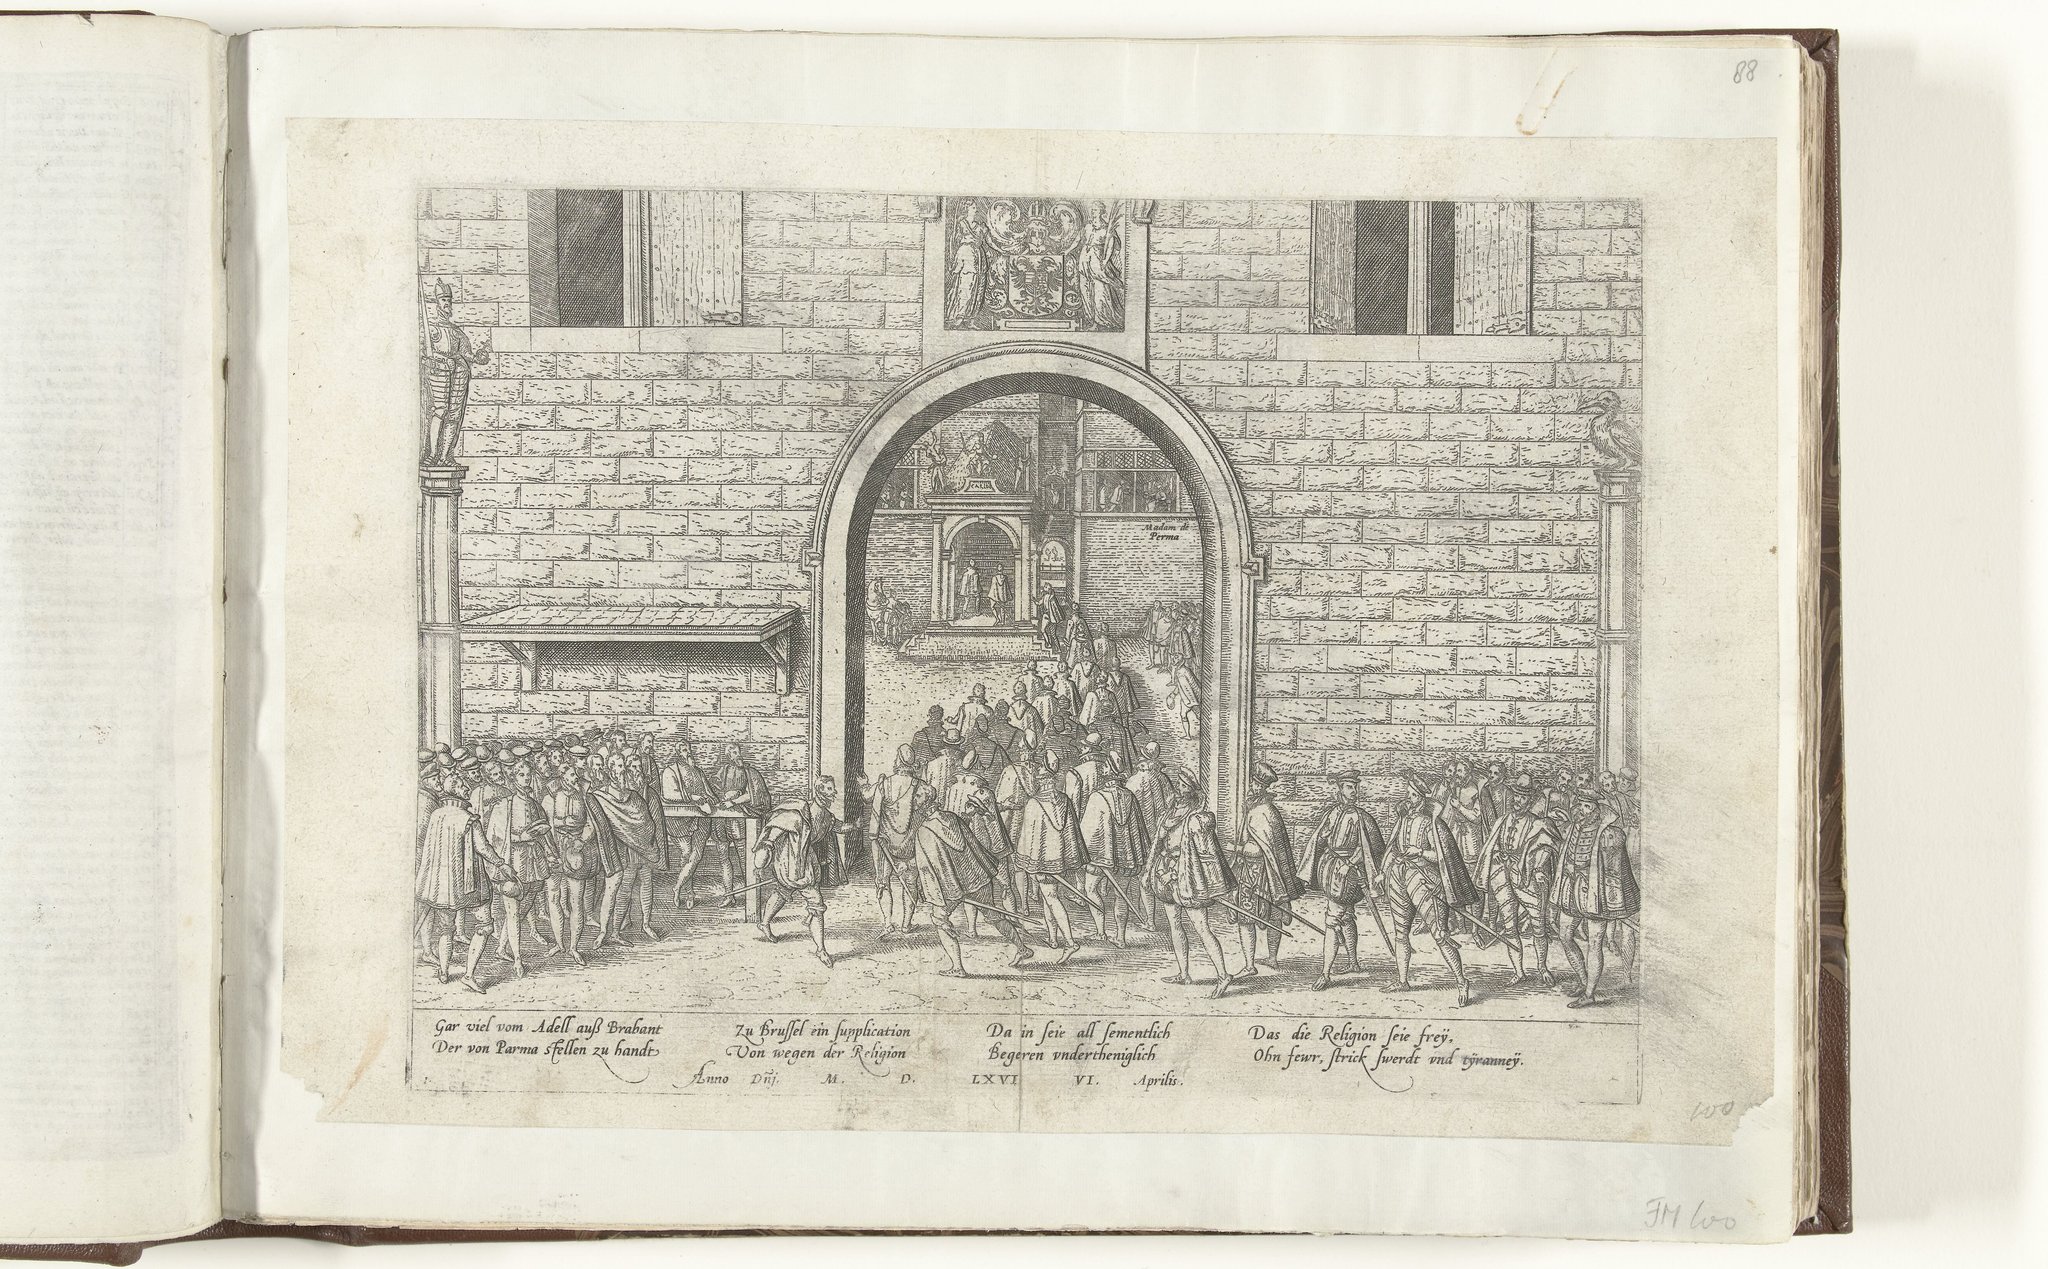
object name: album leaf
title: Serie 5: Nederlandse Gebeurtenissen, 1566-1570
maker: frans hogenberg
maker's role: print maker, publisher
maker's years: 1538-1590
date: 1566-1570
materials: paper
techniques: etching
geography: cologne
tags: oudenaarde, ortona, landvoogd, landvoogdes der nederlanden margaretha van parma, paleis op de koudenberg, tachtigjarige oorlog, smeekschrift der edelen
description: Aanbieding van het Smeekschrift van de edelen. Een stoet van edelen trekt door de poort naar het paleis te Brussel waar het Smeekschrift aangeboden wordt aan Margaretha van Parma, 5 april 1566. Met onderschrift van 8 regels in het Duits. Genummerd: 1.